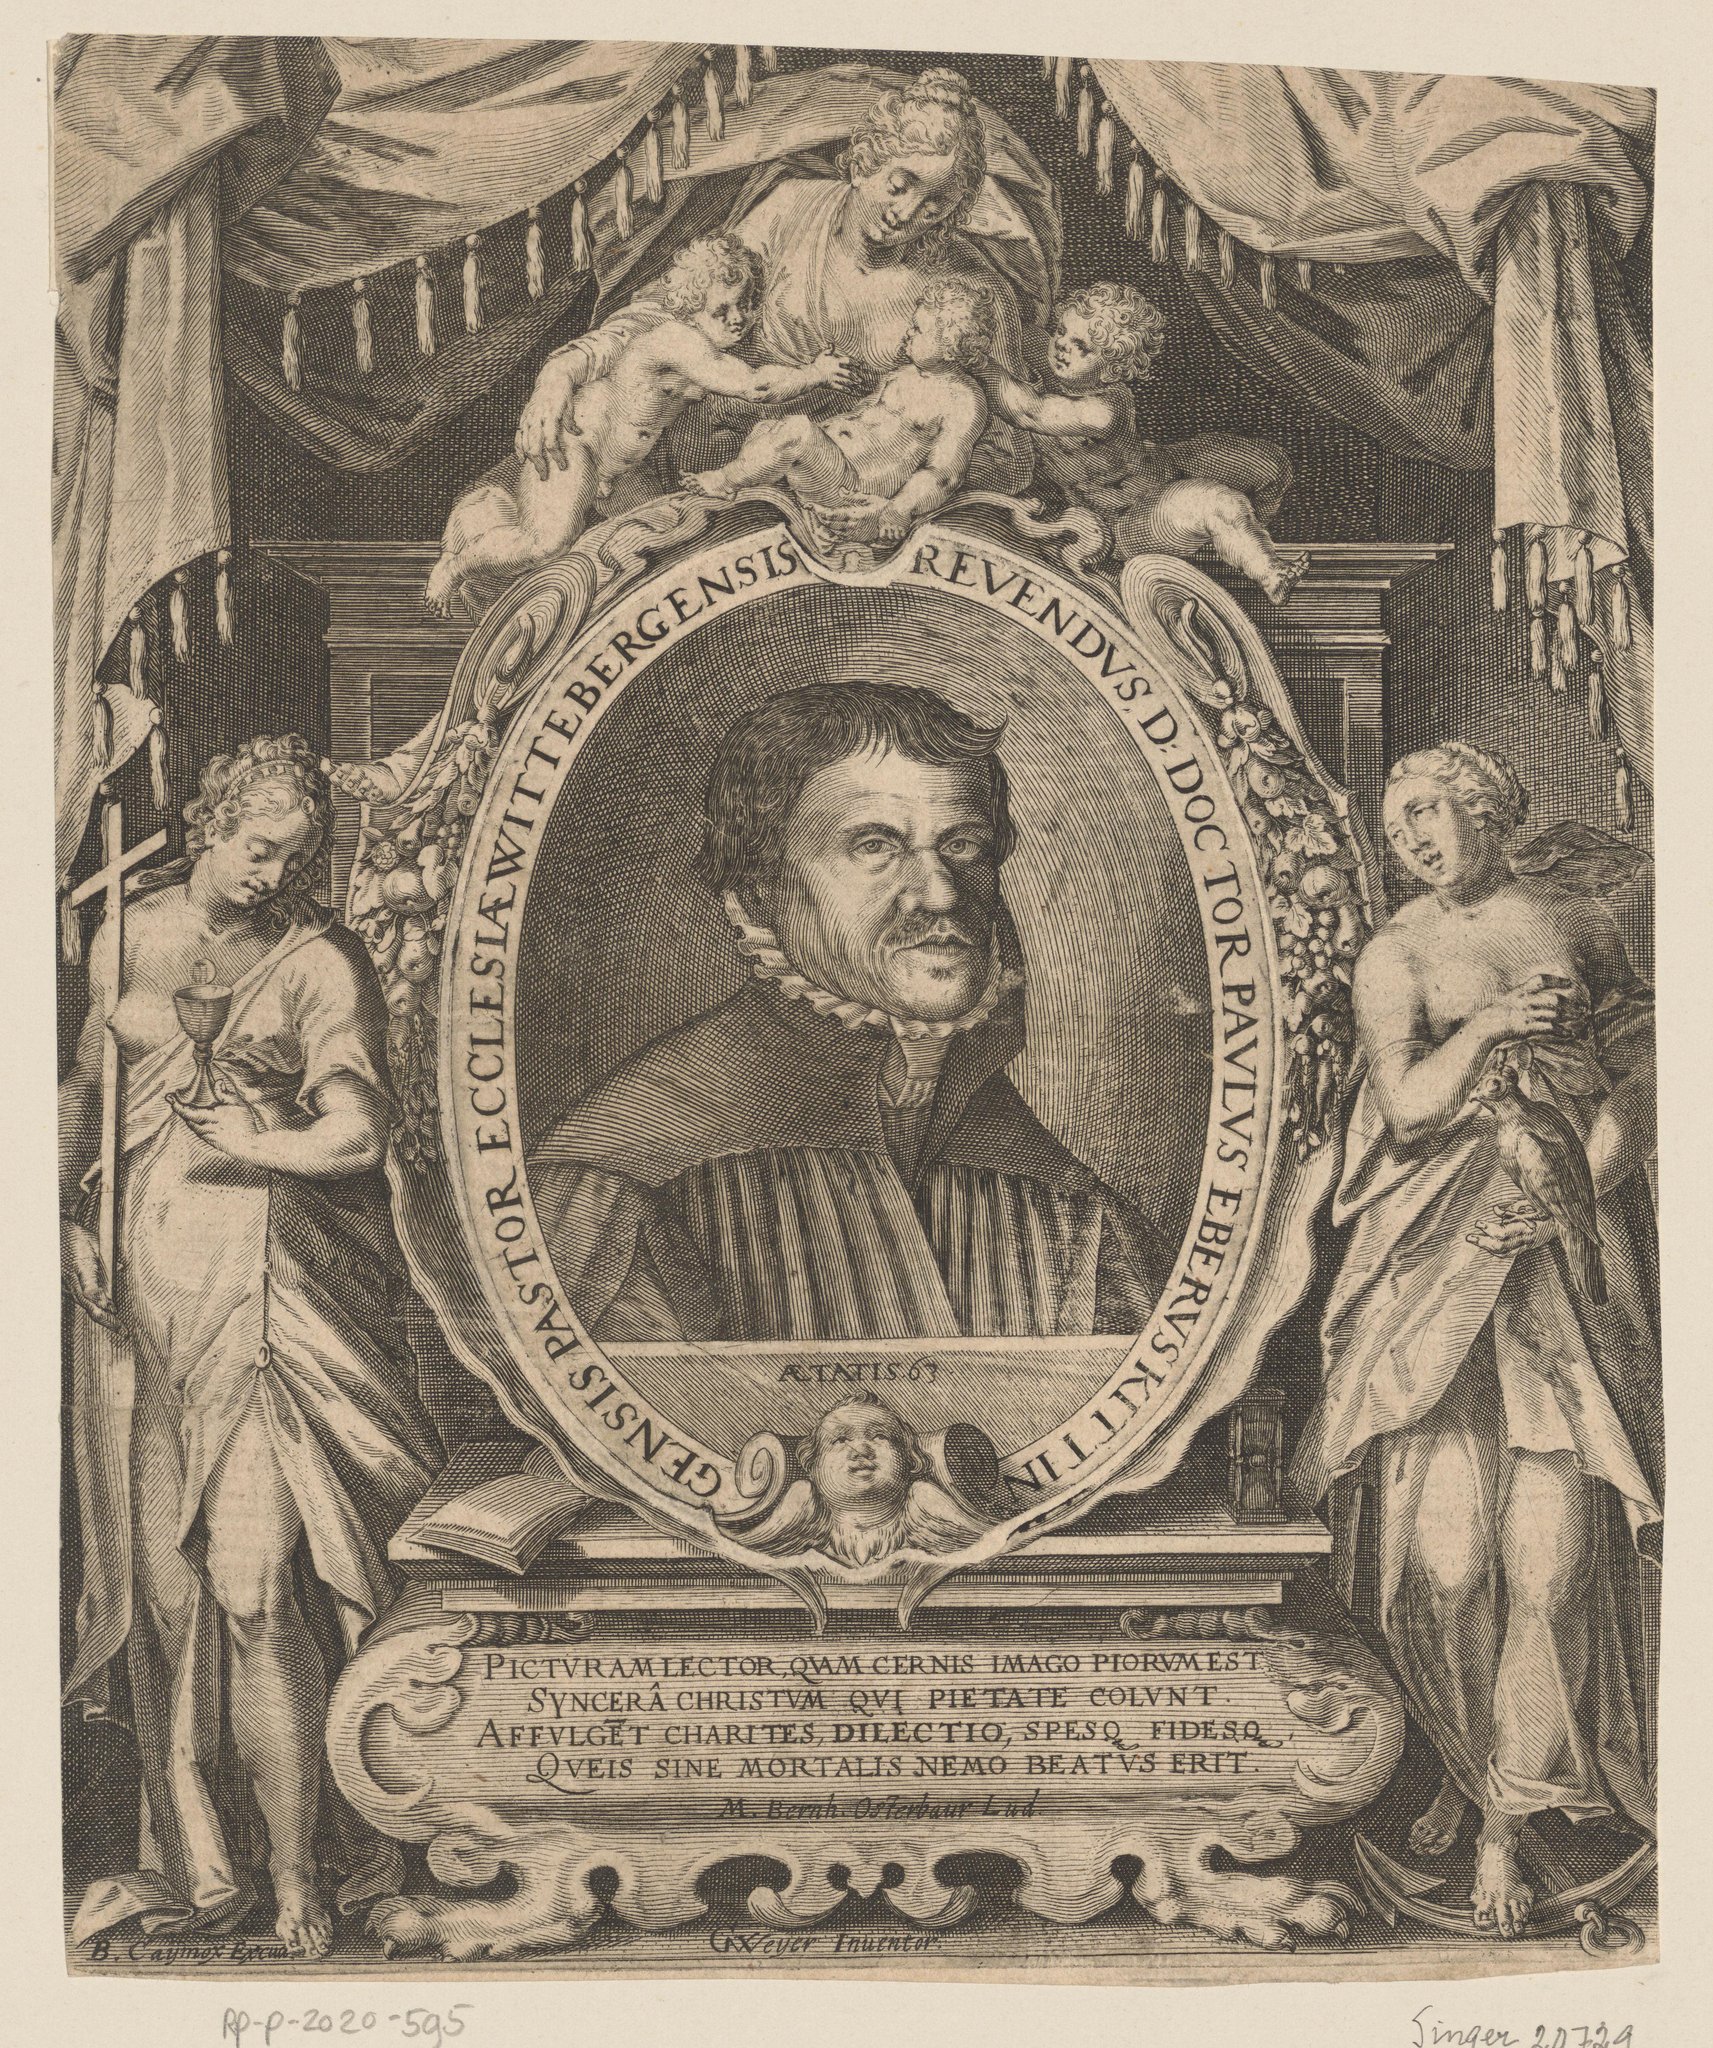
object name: print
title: Portret van Paul Eber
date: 1613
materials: paper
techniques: engraving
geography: germany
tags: the three theological virtues, historical persons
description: Zie voor afdruk zonder omlijsting van tweede plaat: RP-P-2020-1806.